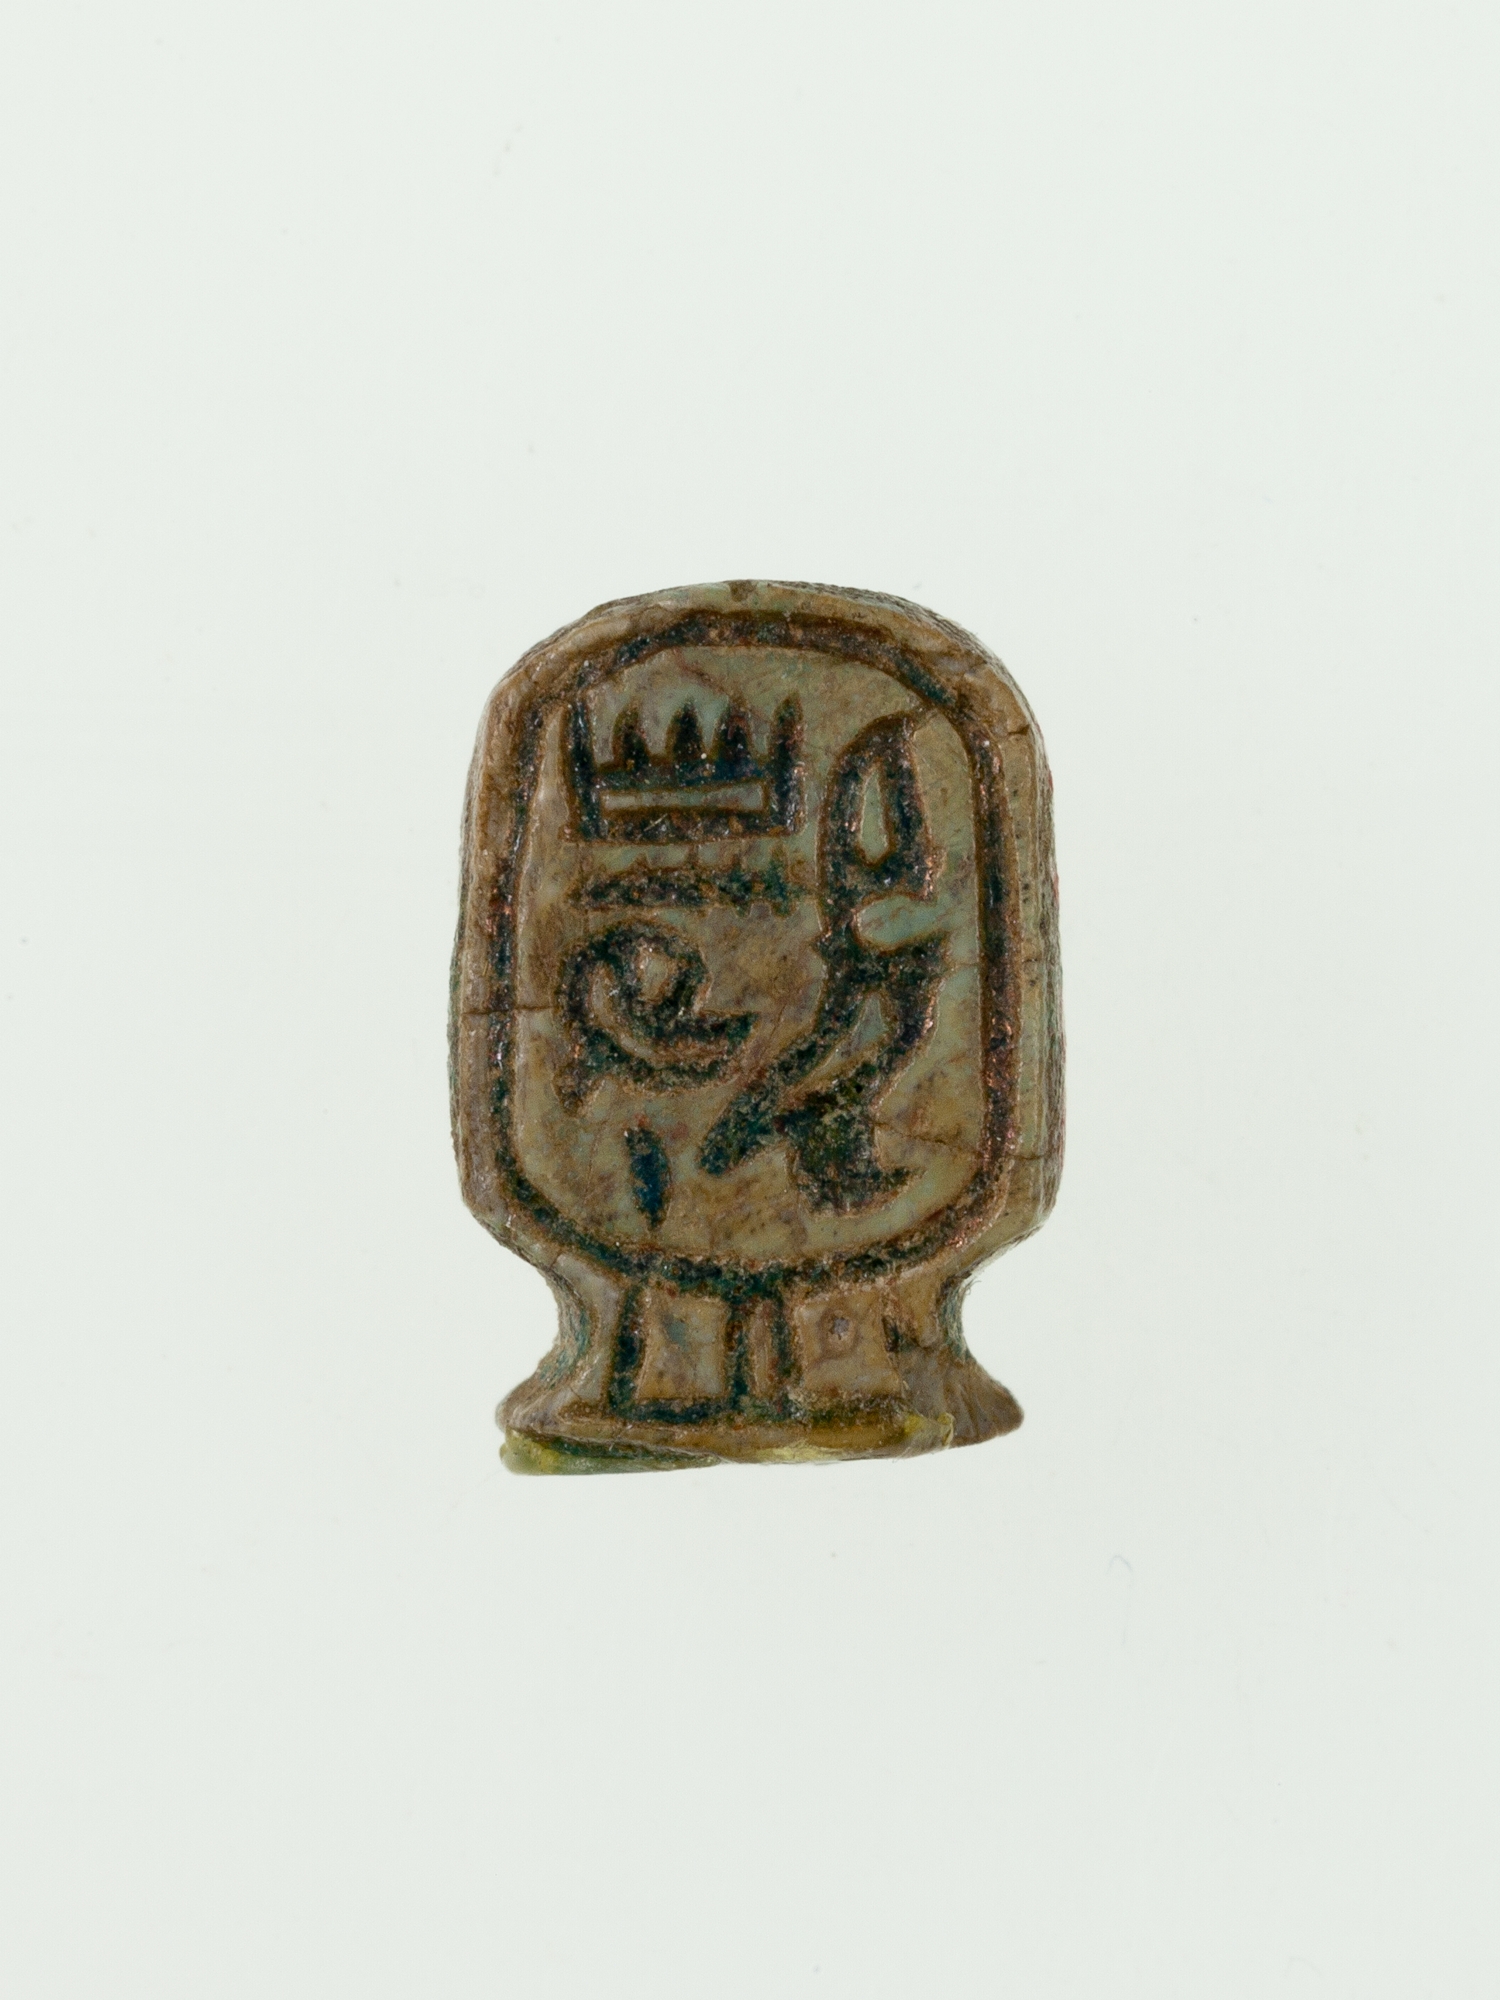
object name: scaraboid, amenemhat iii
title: Scaraboid of Amenemhat III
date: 1859-1813 BCE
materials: stone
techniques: glazing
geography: egypt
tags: hieroglyphs,scarabs